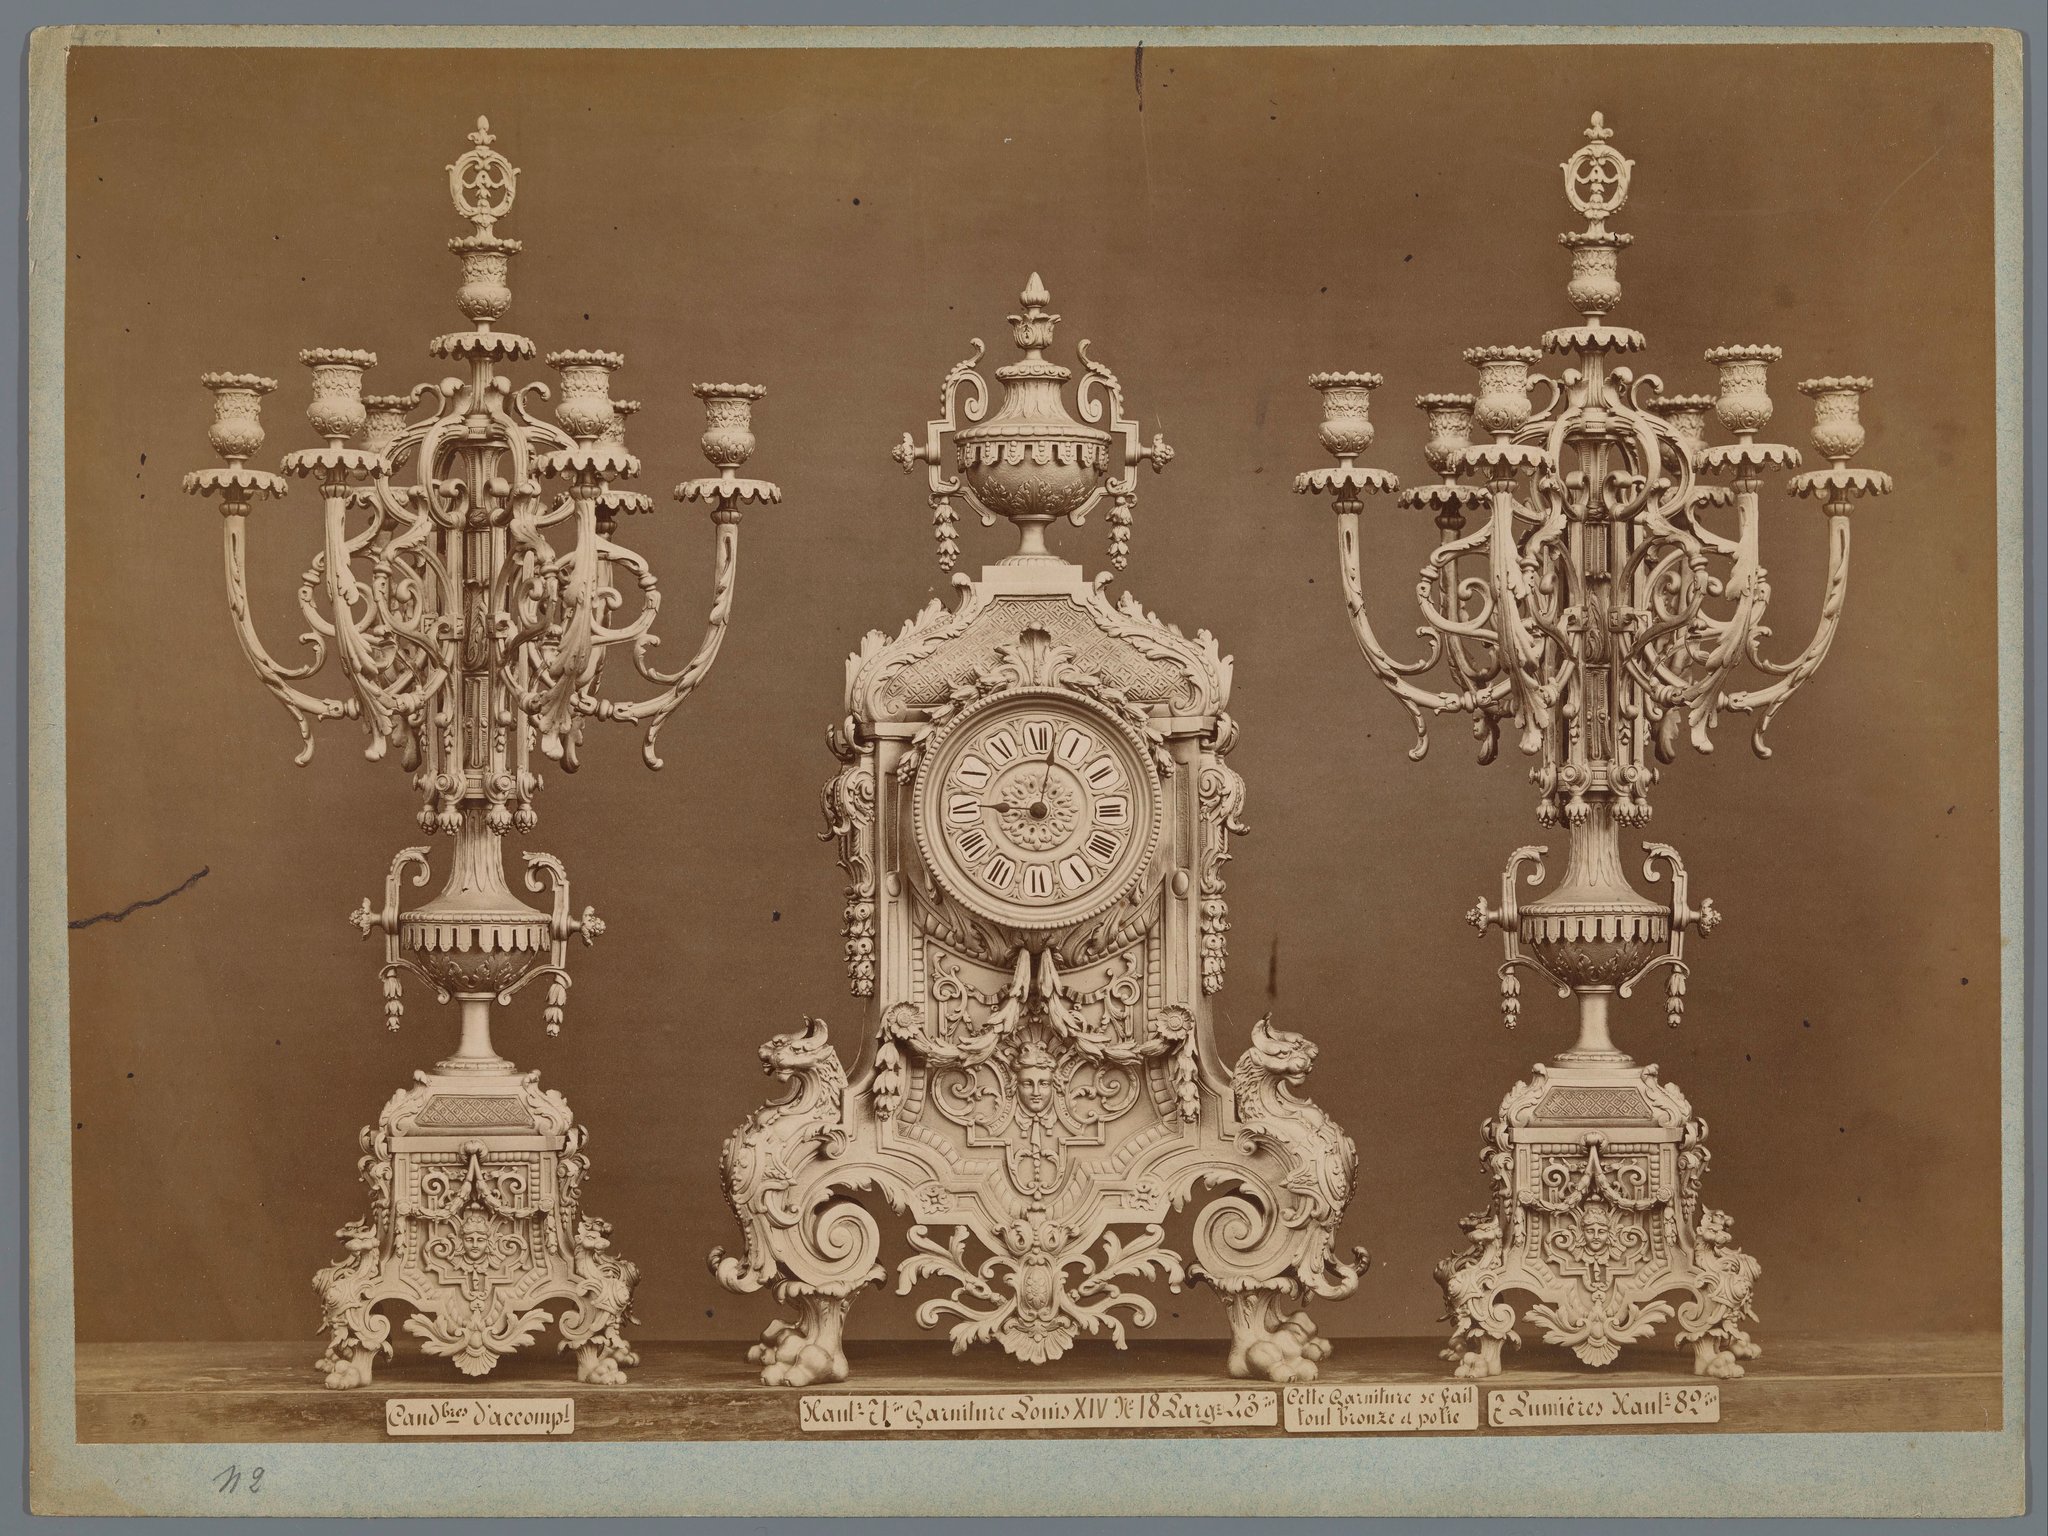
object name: photograph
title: Tafelklok met twee kandelaars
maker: Anonymous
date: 1875-1900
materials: cardboard, photographic support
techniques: albumen print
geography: europe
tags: chandelier, candelabrum, clock, europe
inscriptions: collector's mark: Lugt 3937, number: ‘No 18’, inscription: ‘Hautr 71 Largr 43 Candbres d'accompl Cette Garniture se fait tout bronze et polie Lumières Haute 82’, inscription: ‘XX pl 7’